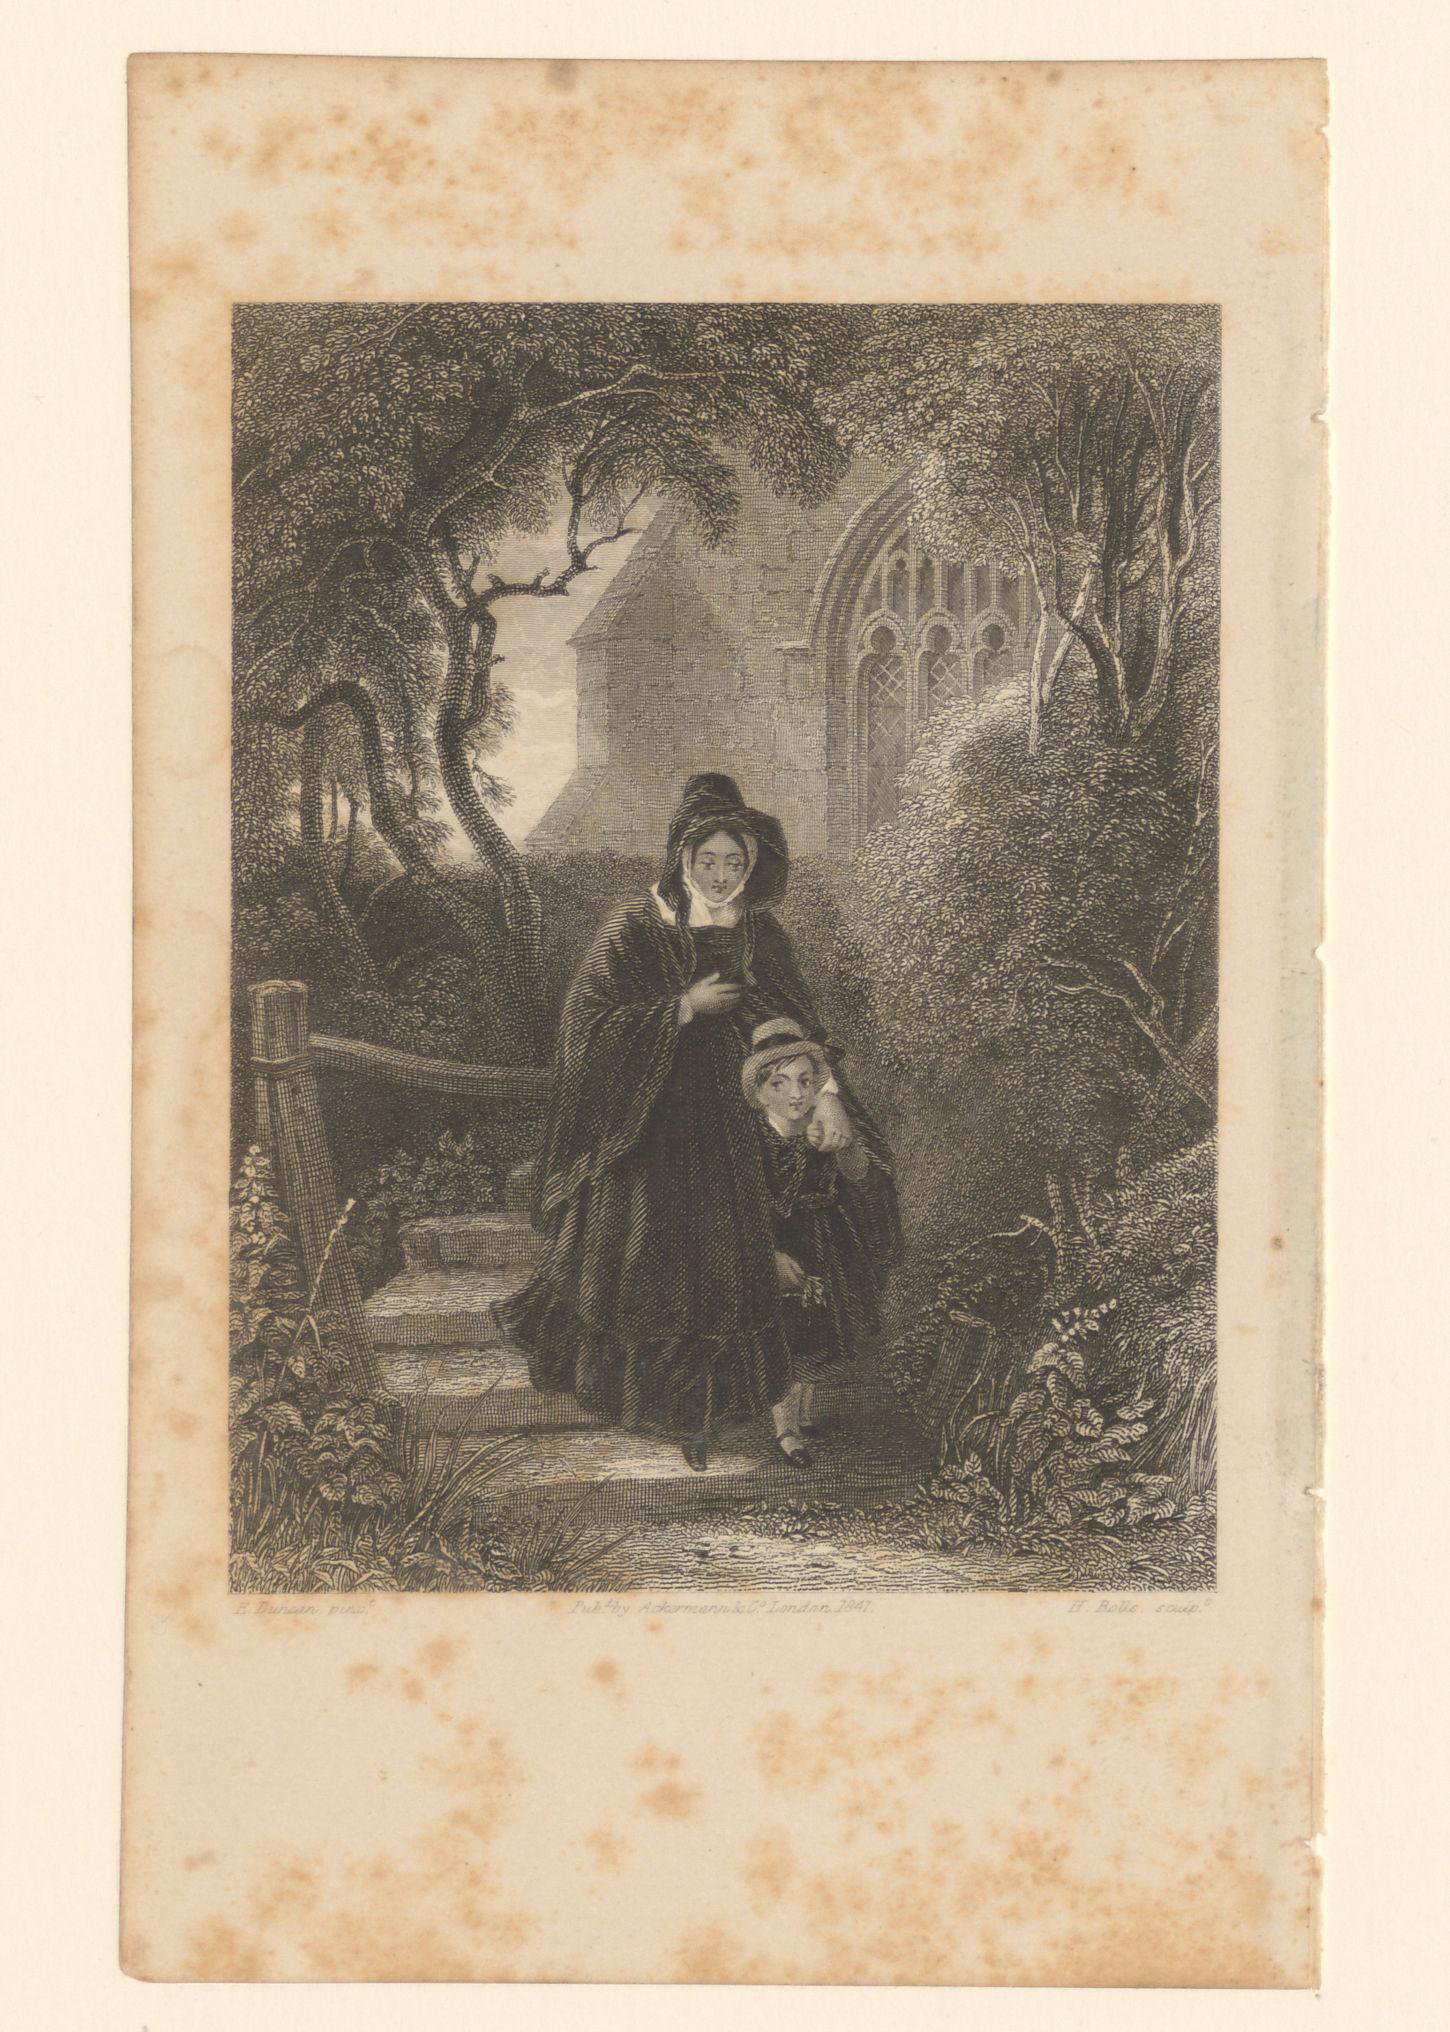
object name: print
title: Vrouw met kind aan de hand komt uit de kerk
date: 1841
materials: paper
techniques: engraving, etching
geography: london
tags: mother and son(s) (family group), roman catholic church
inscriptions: annotation: ‘Aurora, 1841/ Aan [...]’, collector's mark: Lugt 2228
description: Prent gebruikt in: Aurora. Jaarboekje voor 1841. Den Haag: K. Fuhri, 1841.